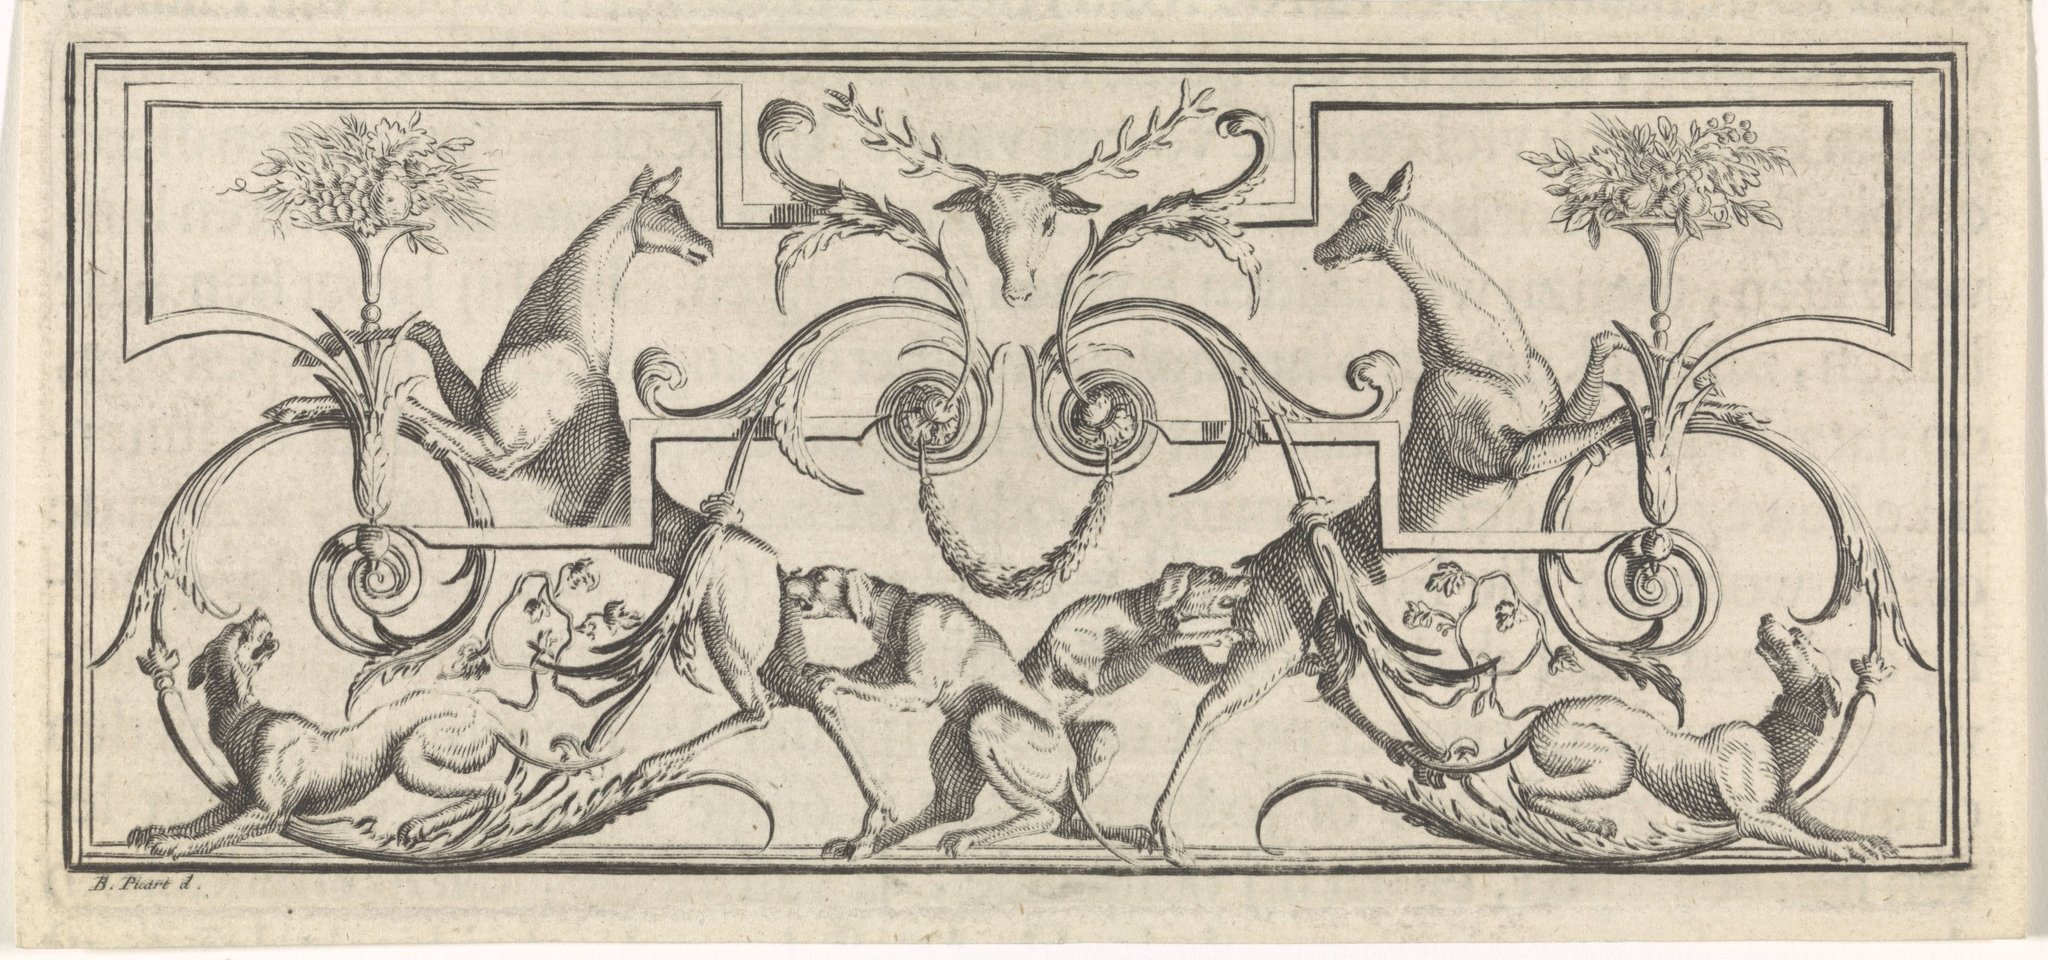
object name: book illustration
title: Ornament met herten, jachthonden en bladranken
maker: bernard picart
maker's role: draughtsman, print maker, publisher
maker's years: 1673-1733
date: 1683-1733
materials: paper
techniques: etching, letterpress printing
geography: amsterdam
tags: ornament derived from animal forms, hoofed animals: deer, hunting dogs, ornament ~ festoon, garland, foliage, tendrils, branches ~ ornament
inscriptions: collector's mark: Lugt 2228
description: Prent oorspronkelijk bedoeld voor: Figures de la Bible. Amsterdam, Bernard Picart, 1720. Prent ook gebruikt in: Taferelen der voornaamste geschiedenissen van het Oude en Nieuwe Testament (...) door de vermaarde kunstenaars Hoet, Houbraken, en Picart getekent (...) en met beschrijvingen uitgebreid. Den Haag: Pieter de Hondt, 1728. Prent kan mogelijk ook zijn gebruikt in andere bijbels.